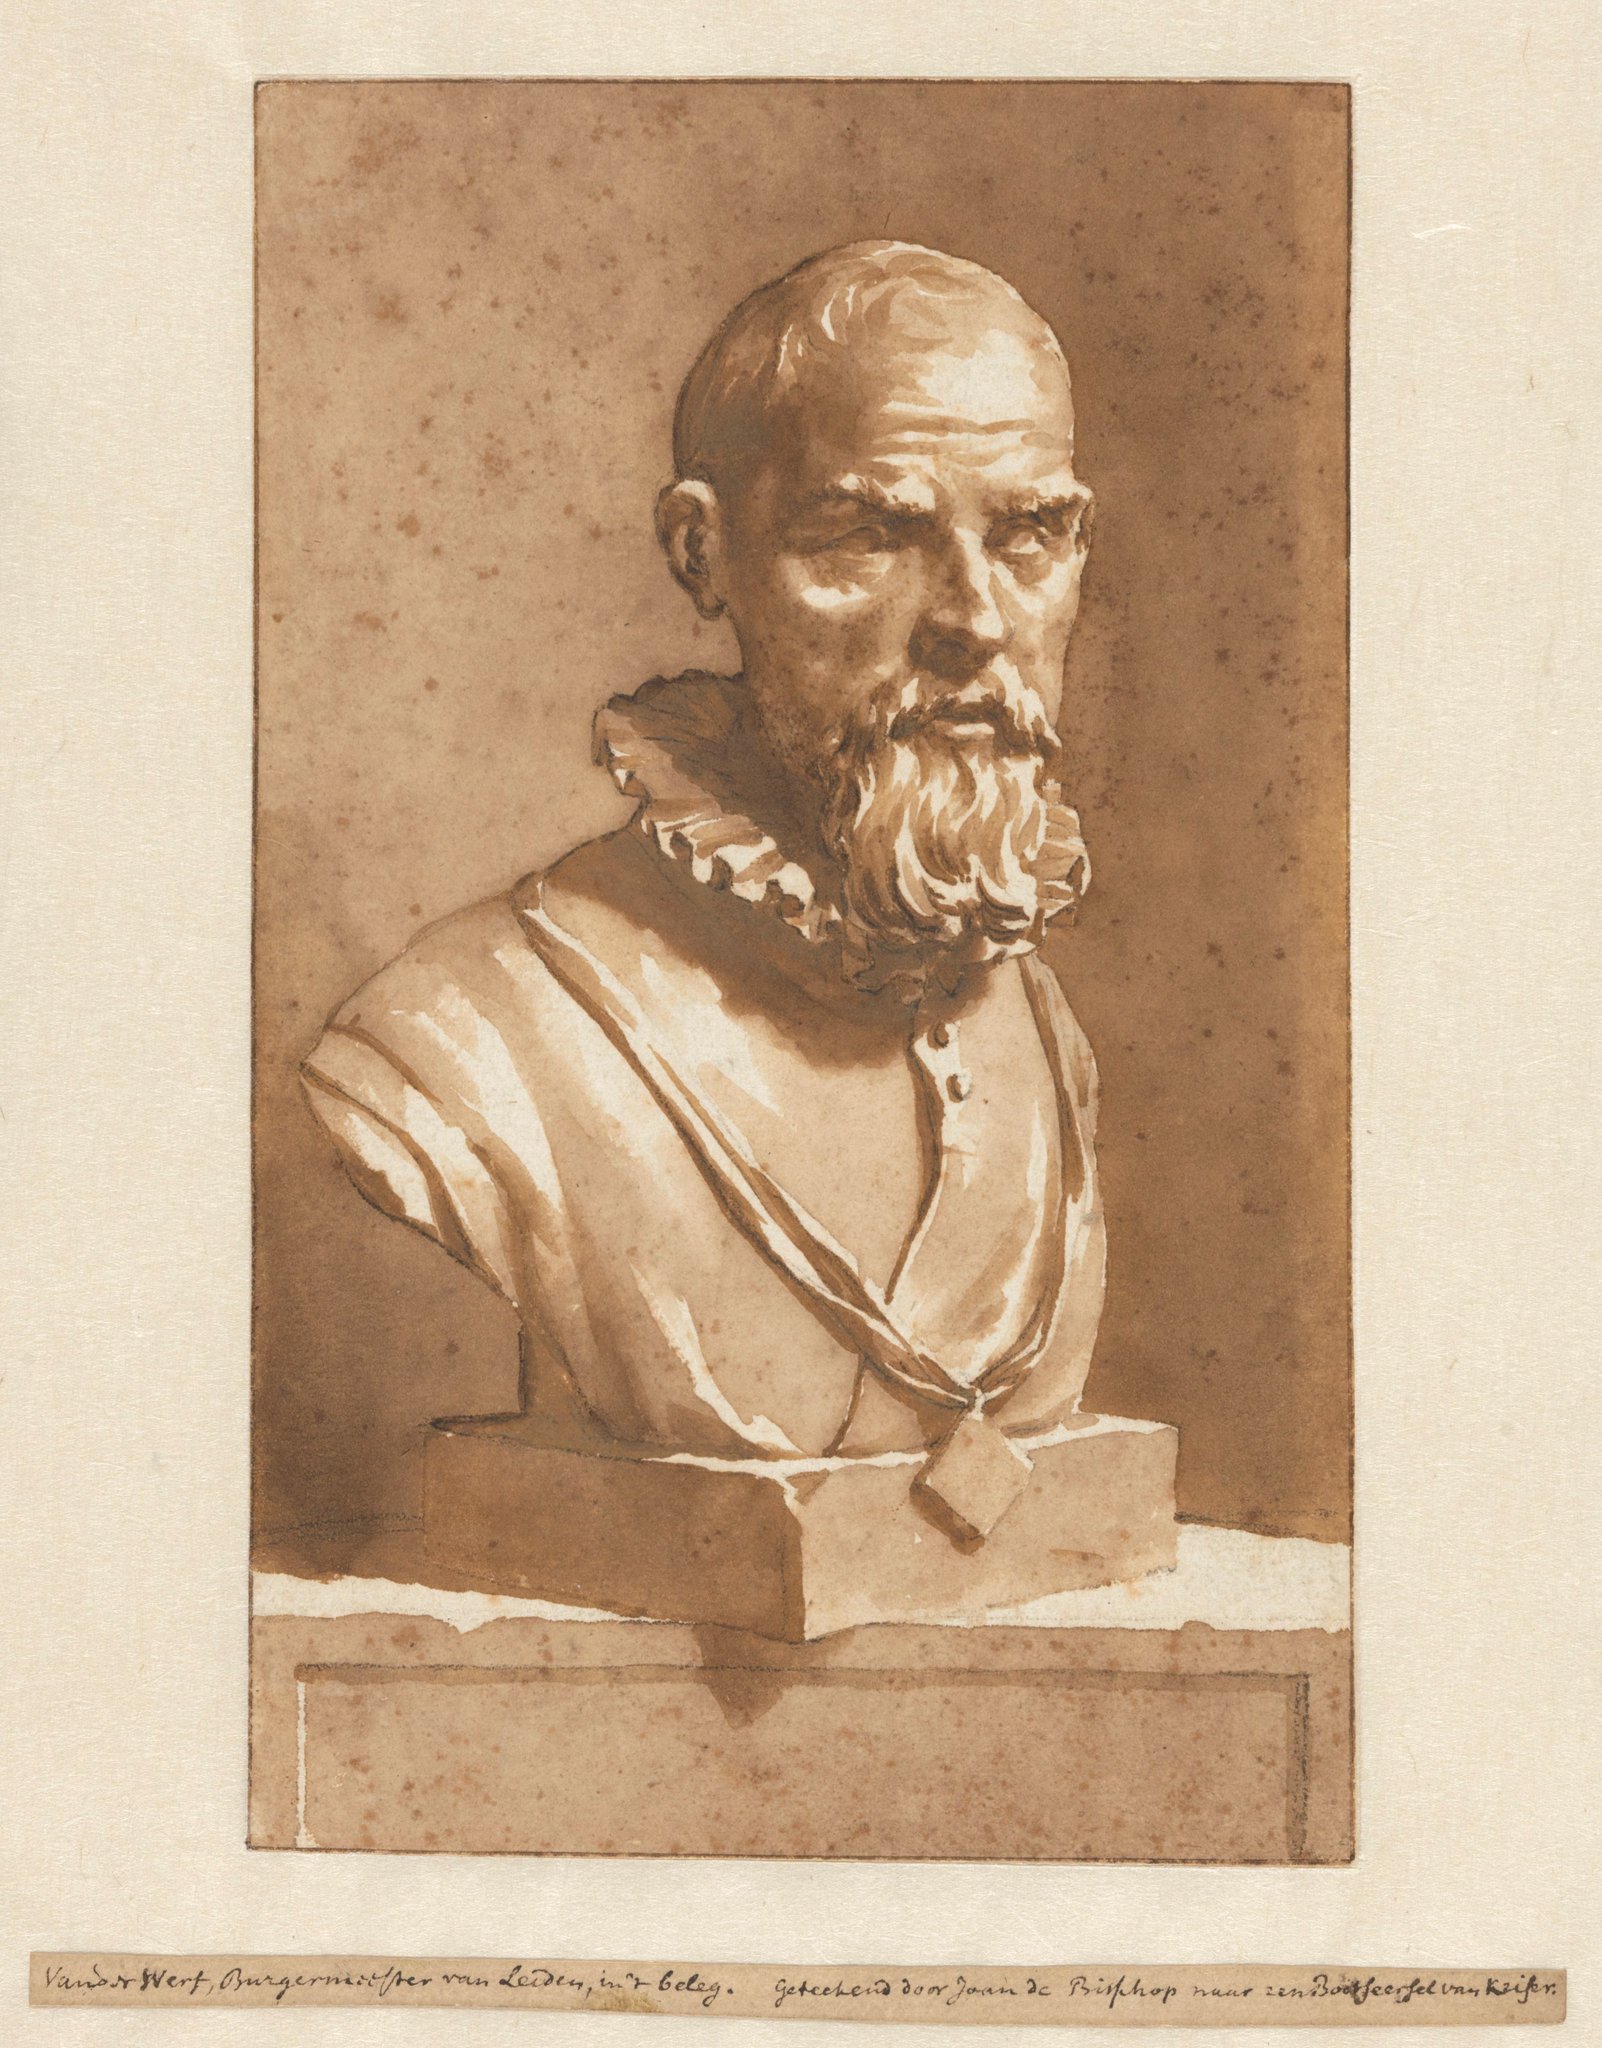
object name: drawing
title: Pieter Adriaensz. van der Werff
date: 1650-1664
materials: chalk, ink, paper, pencil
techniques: drawing, pen, wash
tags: mayor, burgomaster, historical persons, piece of sculpture, reproduction of a piece of sculpture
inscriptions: : ‘Burgermeester van Leiden, in't beleg. Geteekend door Joan de Bisschop naar een Boetseersel van Keiser’, inscription: ‘J de Bisschop /hoog 8 1/2 / br 5 1/4’, inscription: ‘Burgermeester Vander Werff/ van Leyden’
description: Buste in terracotta van de Leidse burgemeester Van der Werff. Het beeld is met zijn blokvormige voet overhoeks en iets overstekend in een muurnis.